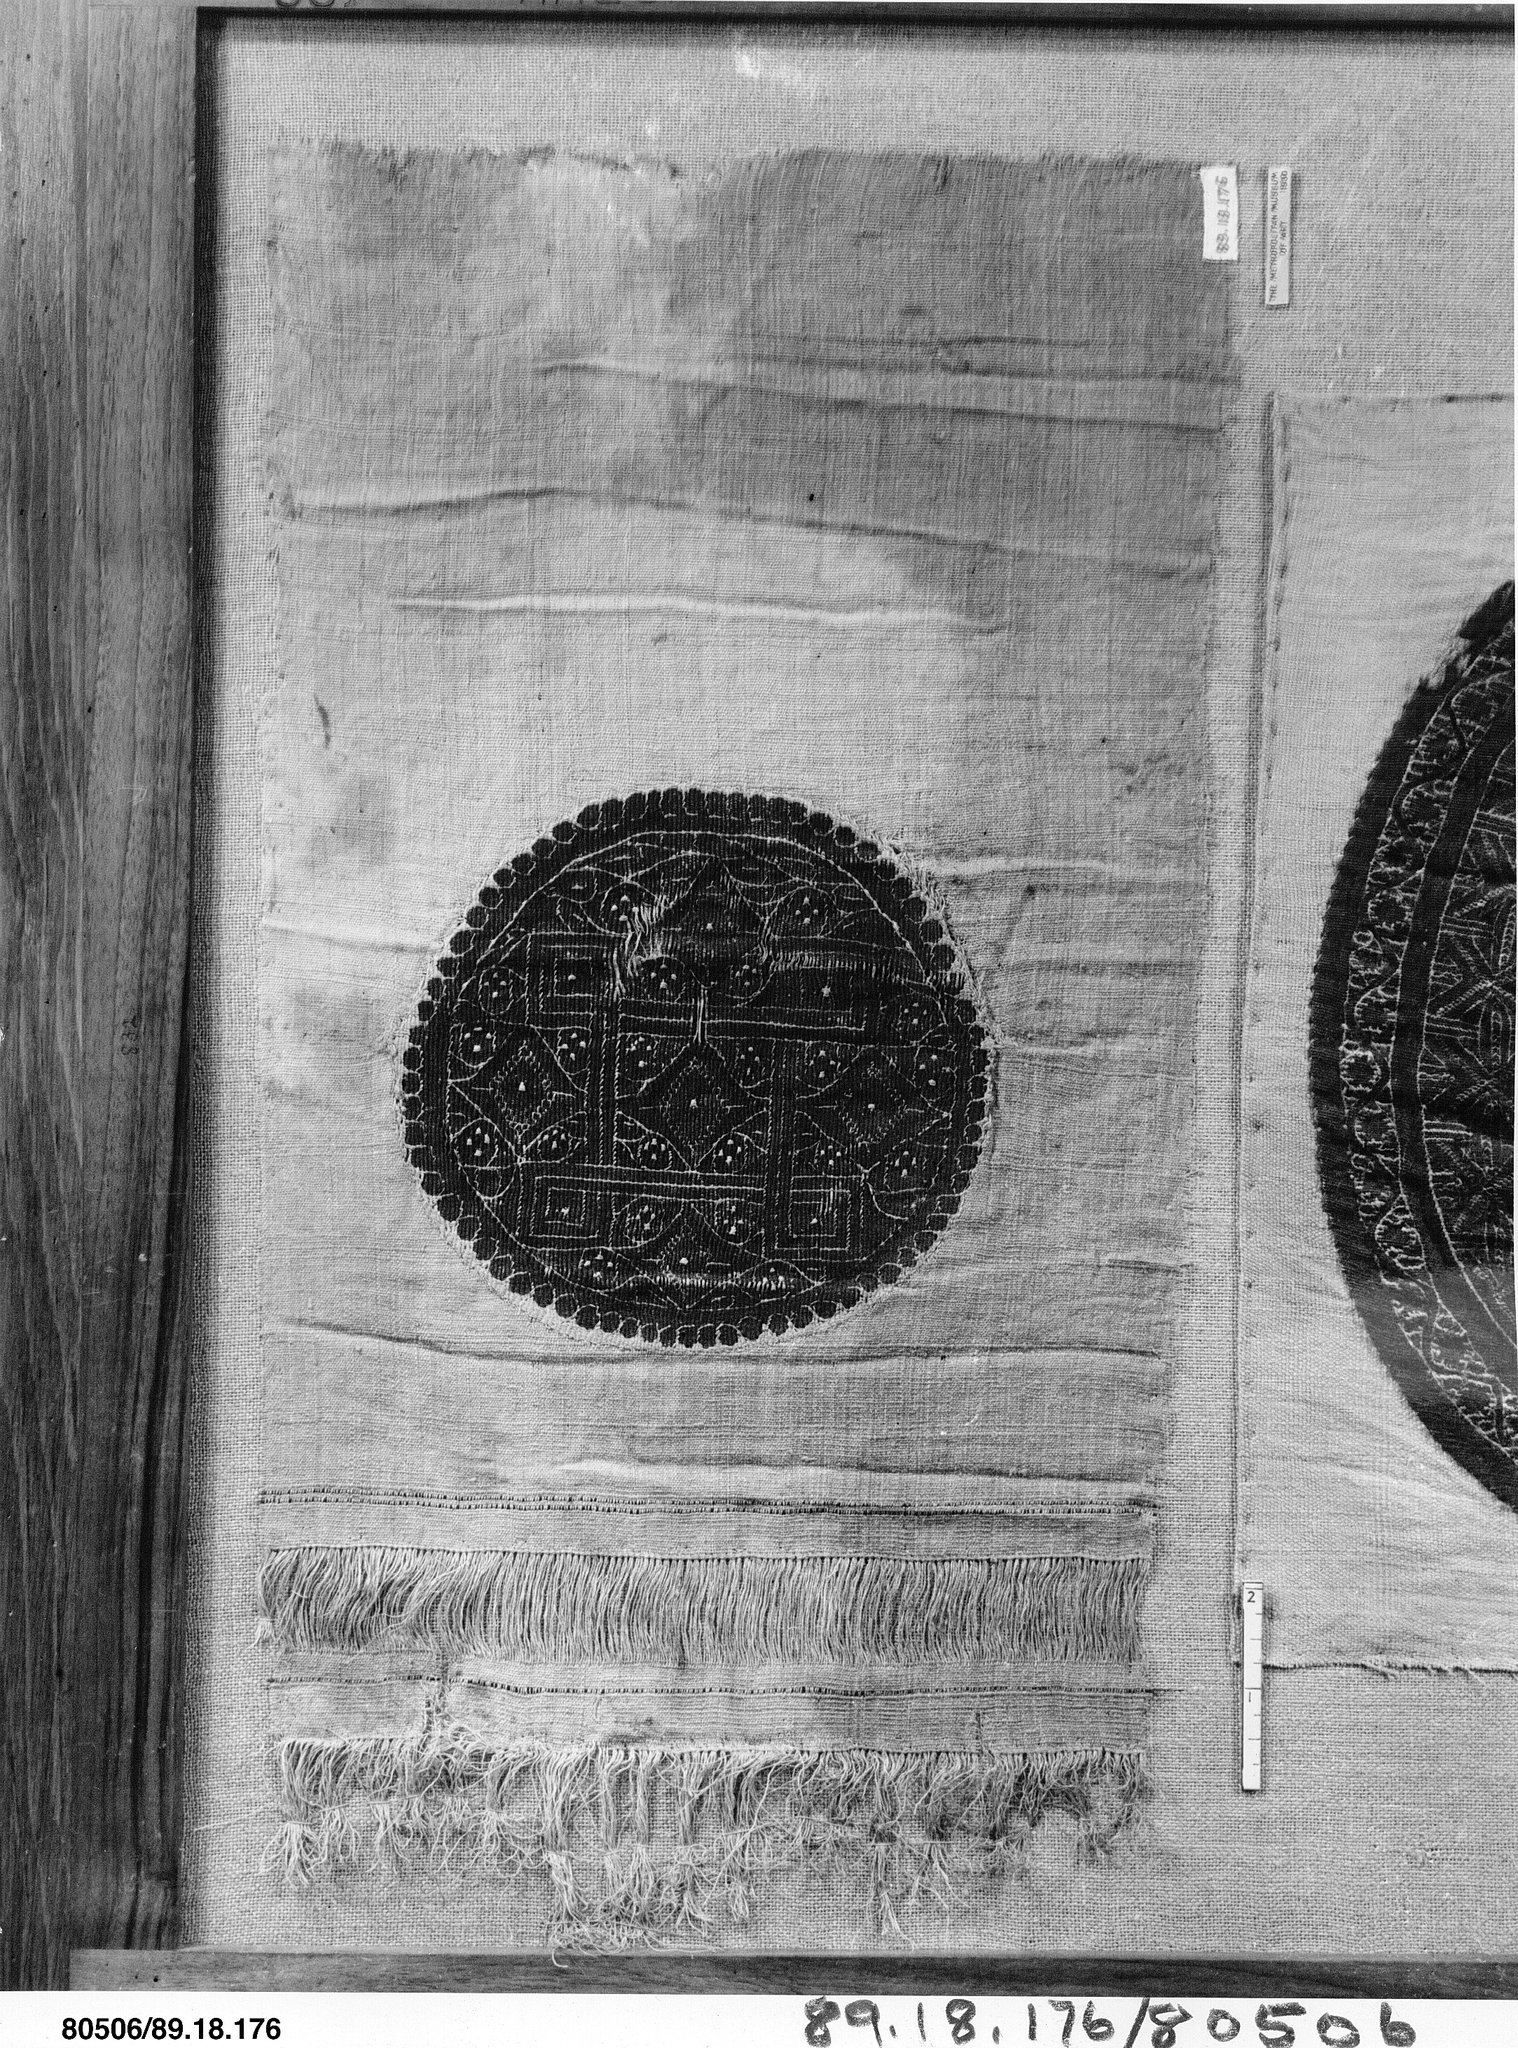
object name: textile fragment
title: Fragment with an Interlace Medallion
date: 201-600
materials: linen, wool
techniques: weave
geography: egypt